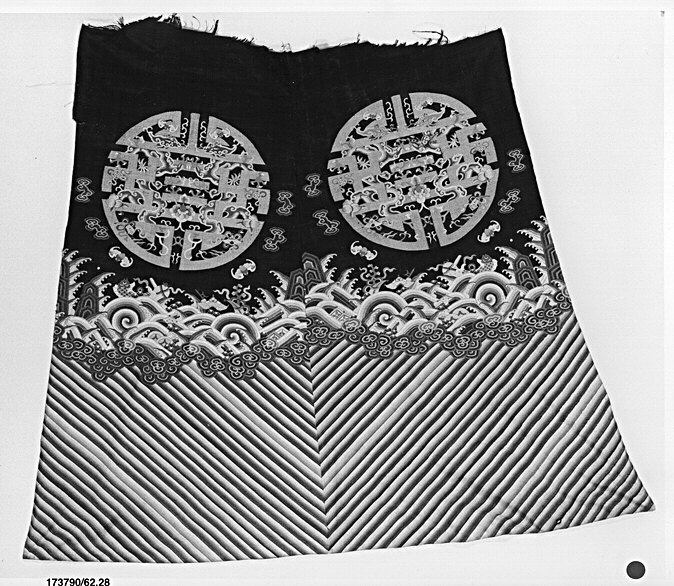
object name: robe, court, section of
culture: chinese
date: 1801-1900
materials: metal thread, silk